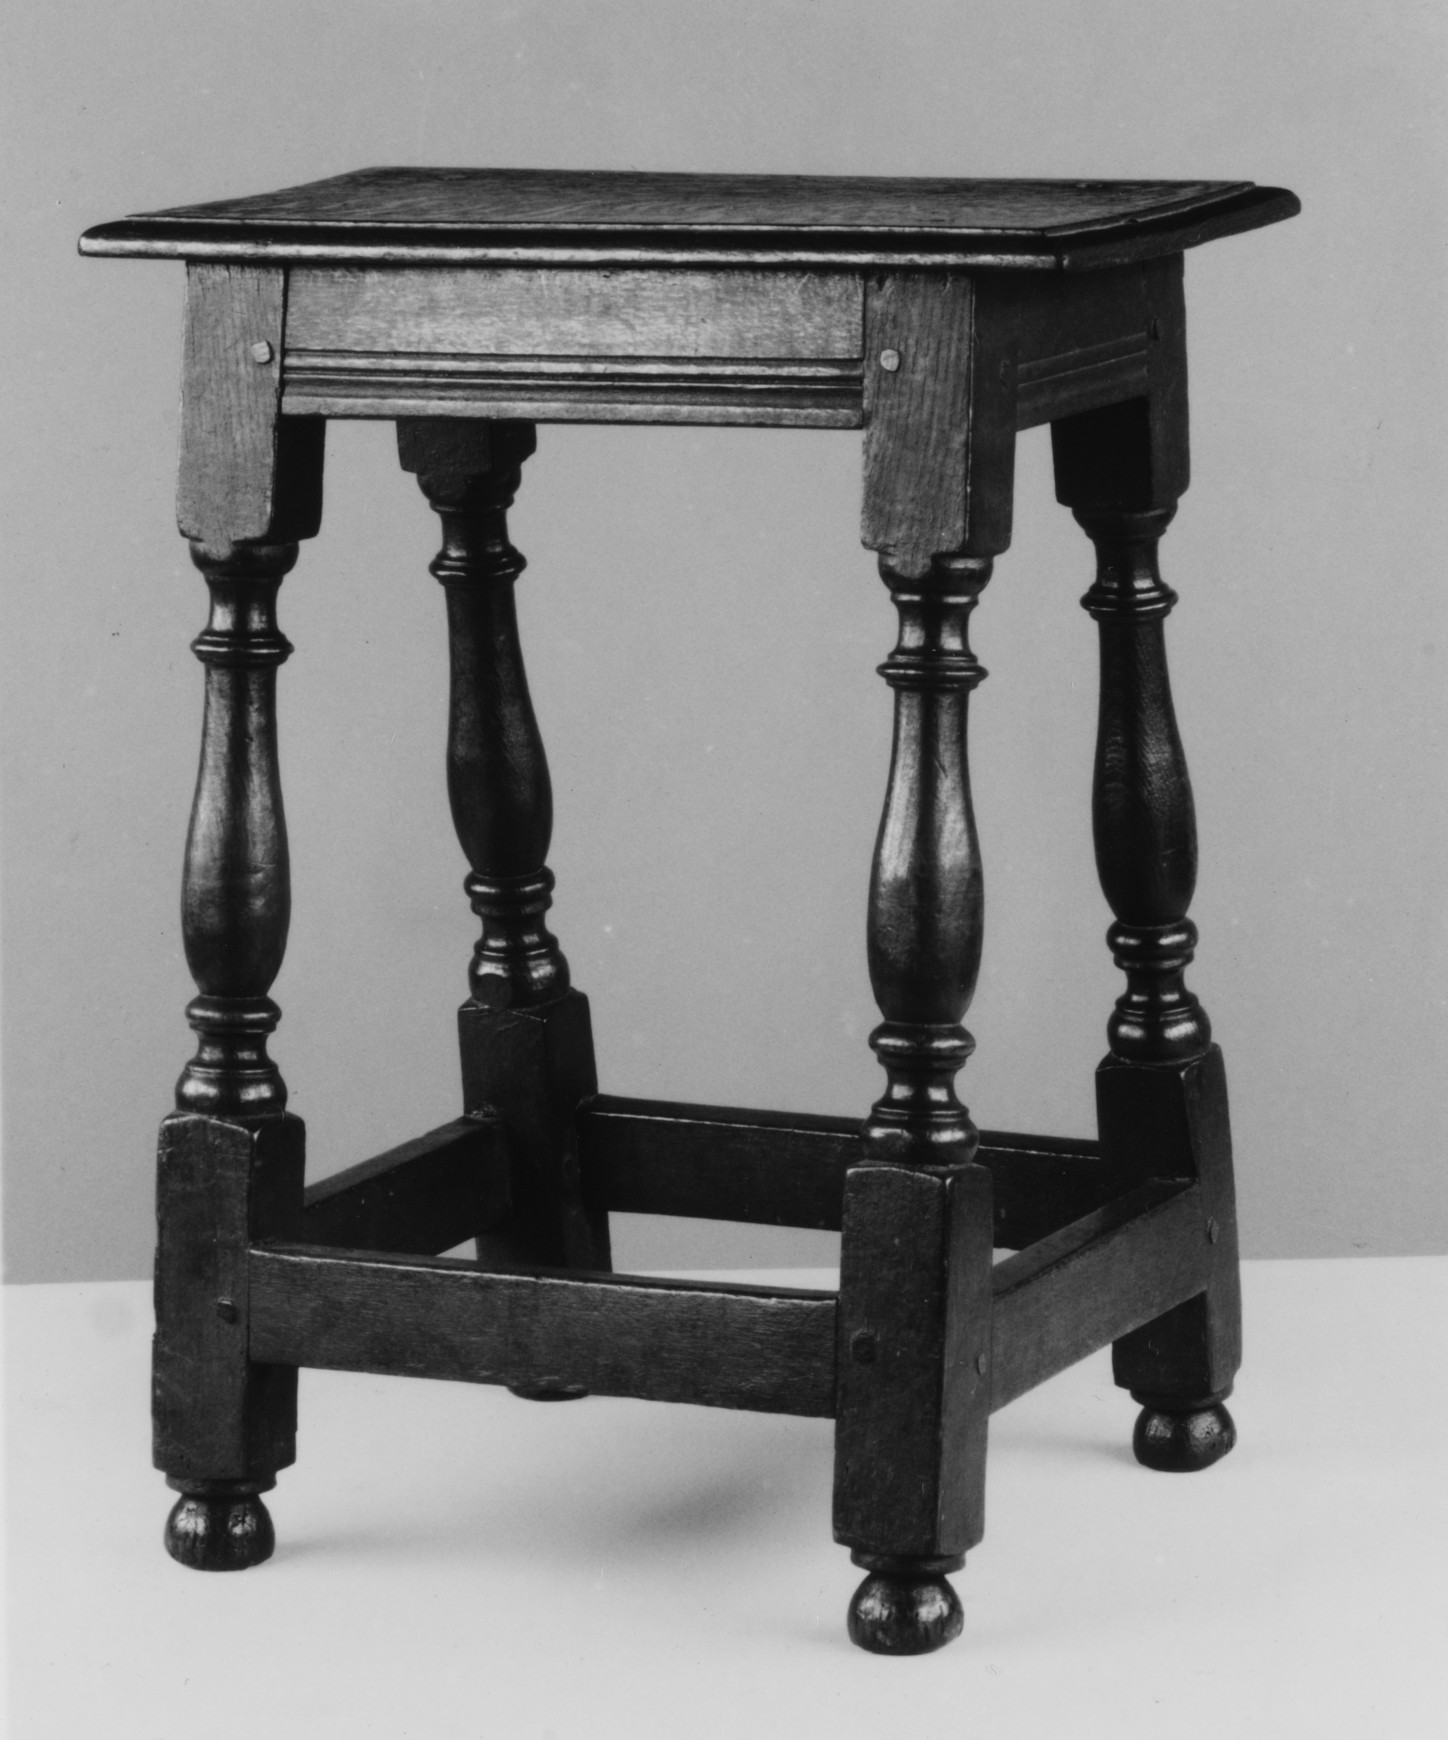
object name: joint stool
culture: british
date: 1650-1700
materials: wood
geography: england